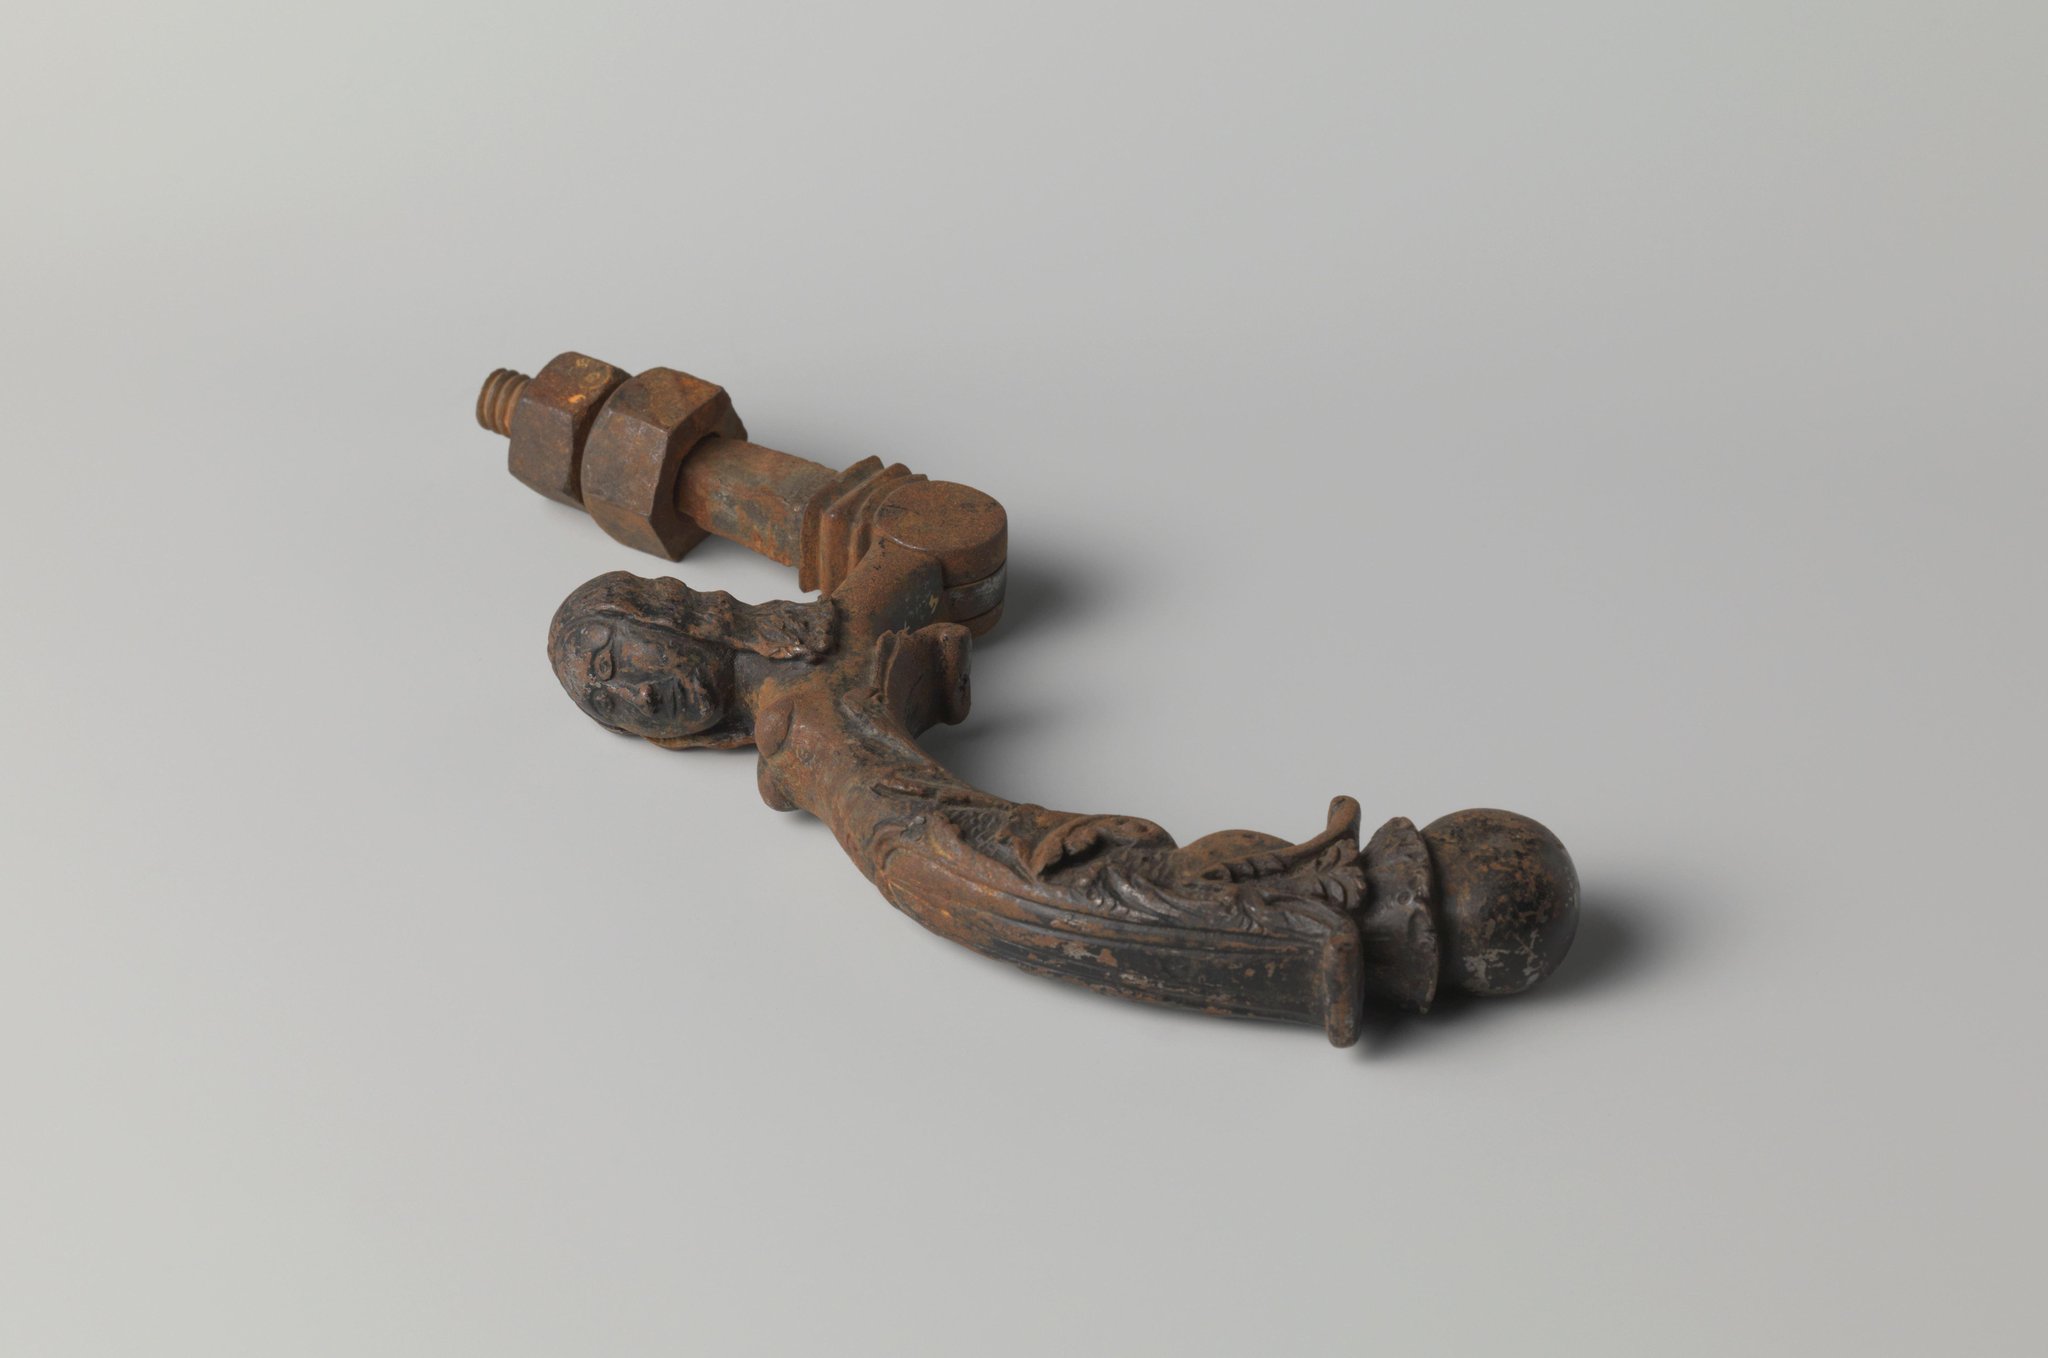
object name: door knocker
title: Deurklopper met in dolfijnenkop eindigende vrouwenfiguur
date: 1575-1600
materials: iron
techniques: repoussé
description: Een ijzeren gedreven deurklopper, voorstellende een vrouw, eindigende in een dolfijnkop.